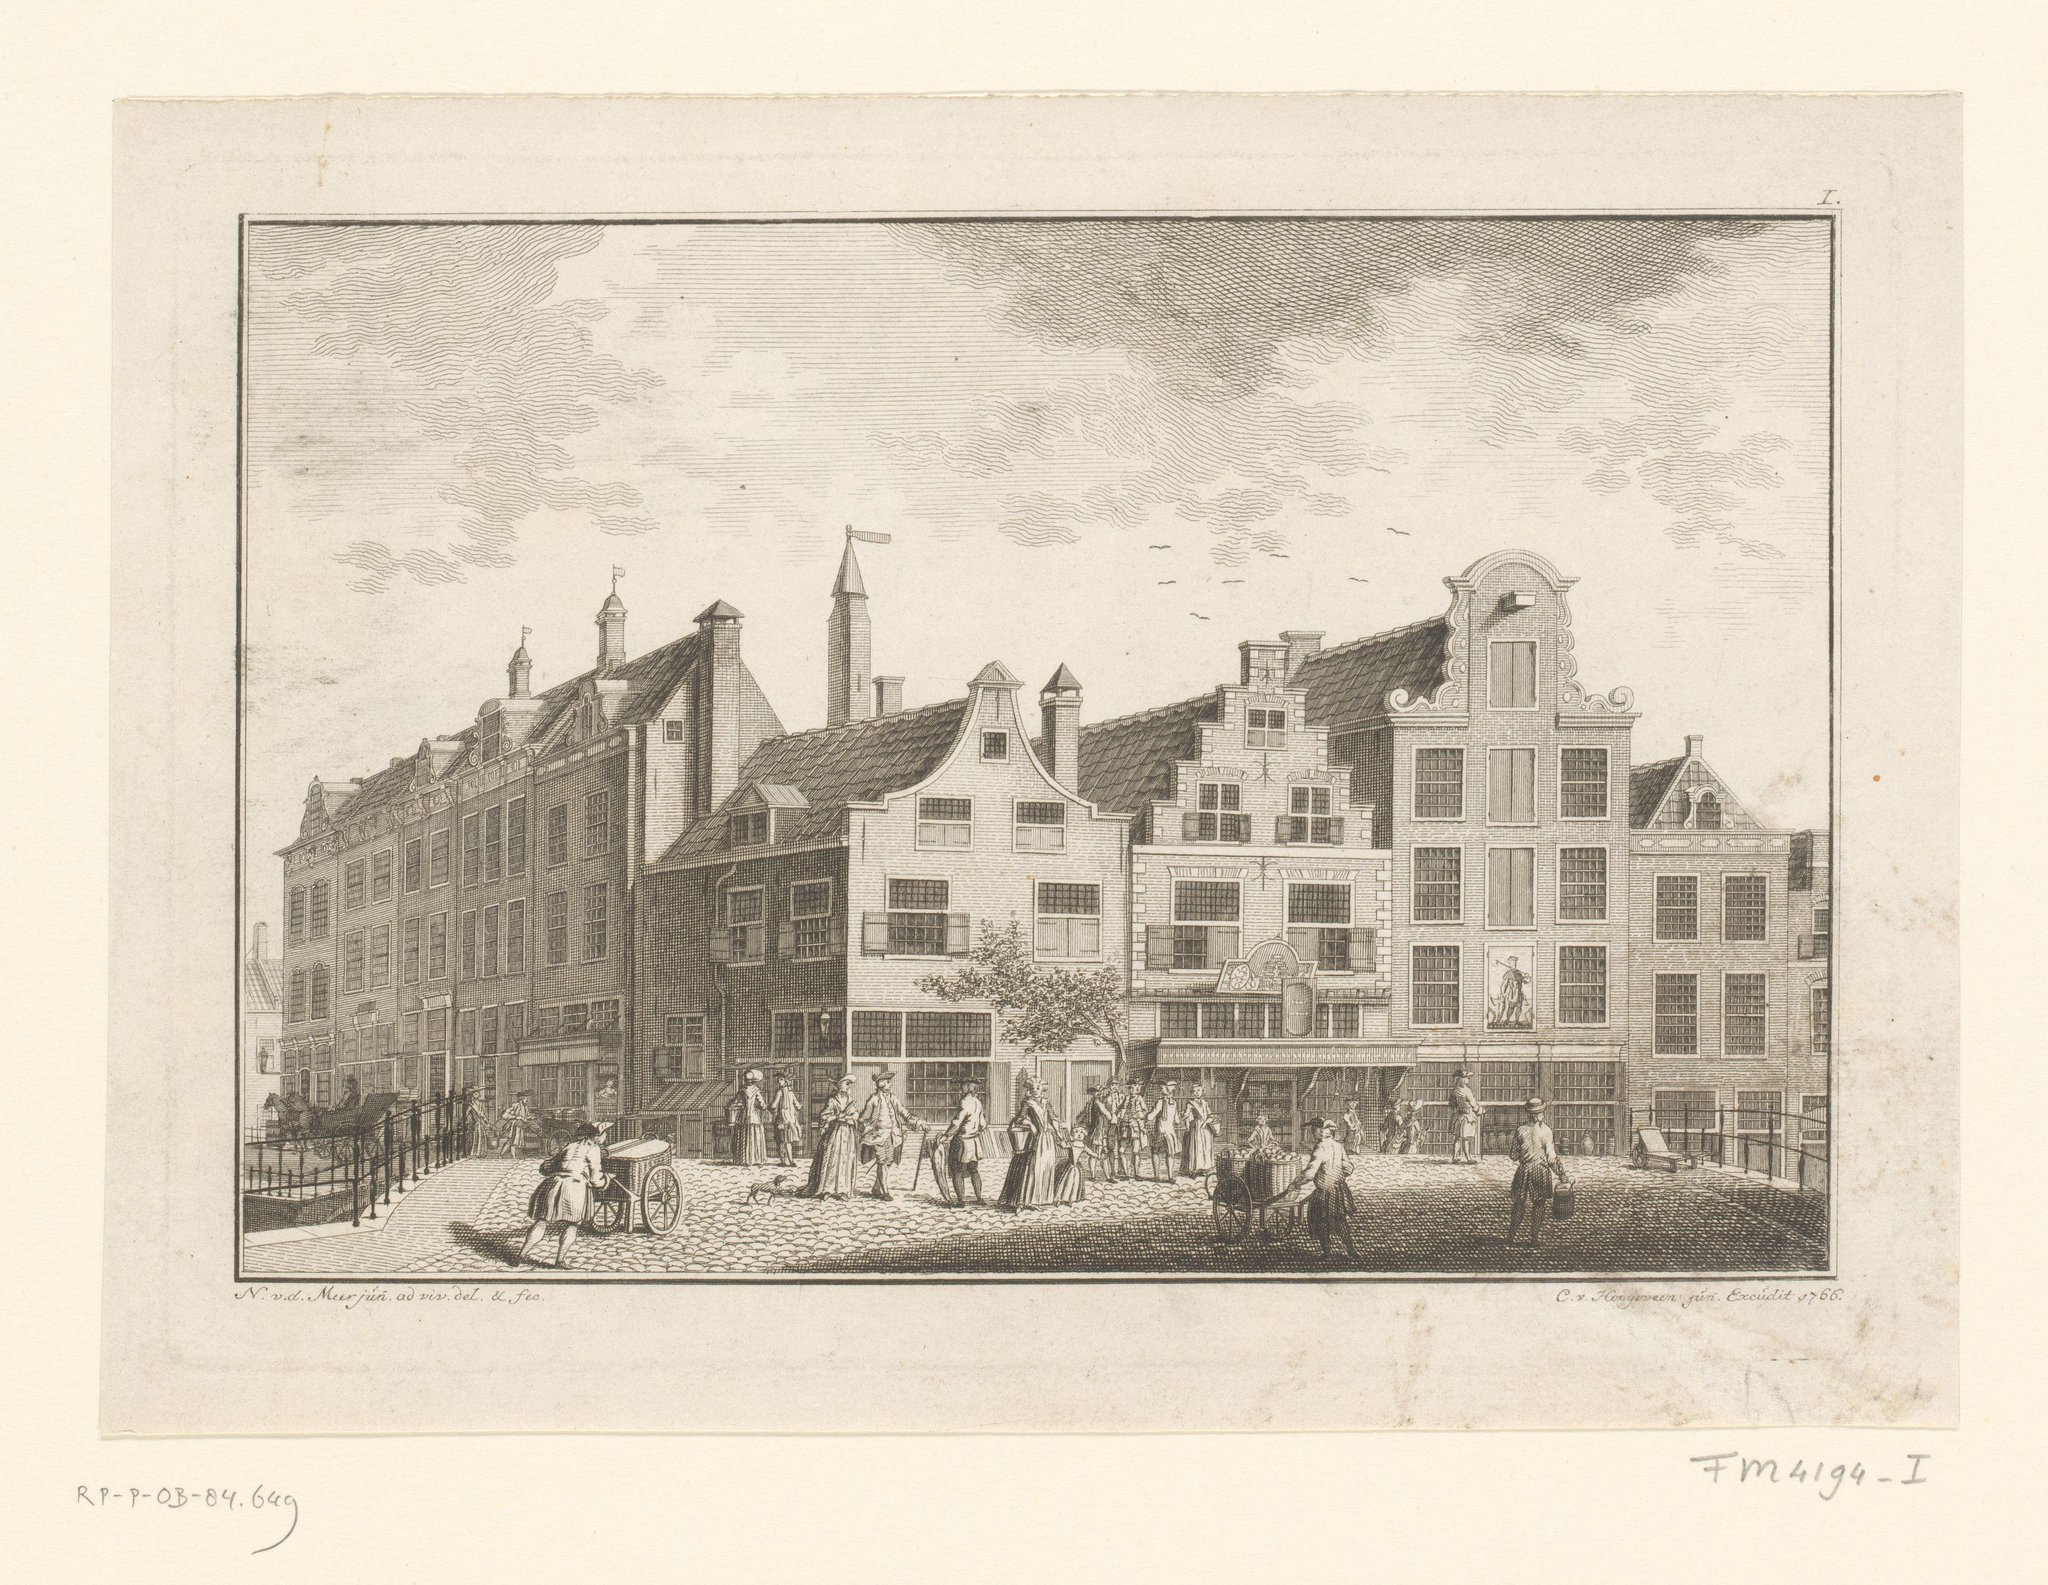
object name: print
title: Huizen aan de Visbrug te Leiden, vóór de brand van 1766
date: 1766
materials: paper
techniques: engraving, etching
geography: leiden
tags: façade (of house or building), bridge, civic architecture; edifices; dwellings, leiden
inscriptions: collector's mark: Lugt 2228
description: De huizen in welstand. Gezicht op de huizen aan de Visbrug en Hoogstraat te Leiden, vóór de brand van 3 oktober 1766. Rechtsboven genummerd: I. Onderdeel van een serie van vijf platen over de brand van 1766 te Leiden.